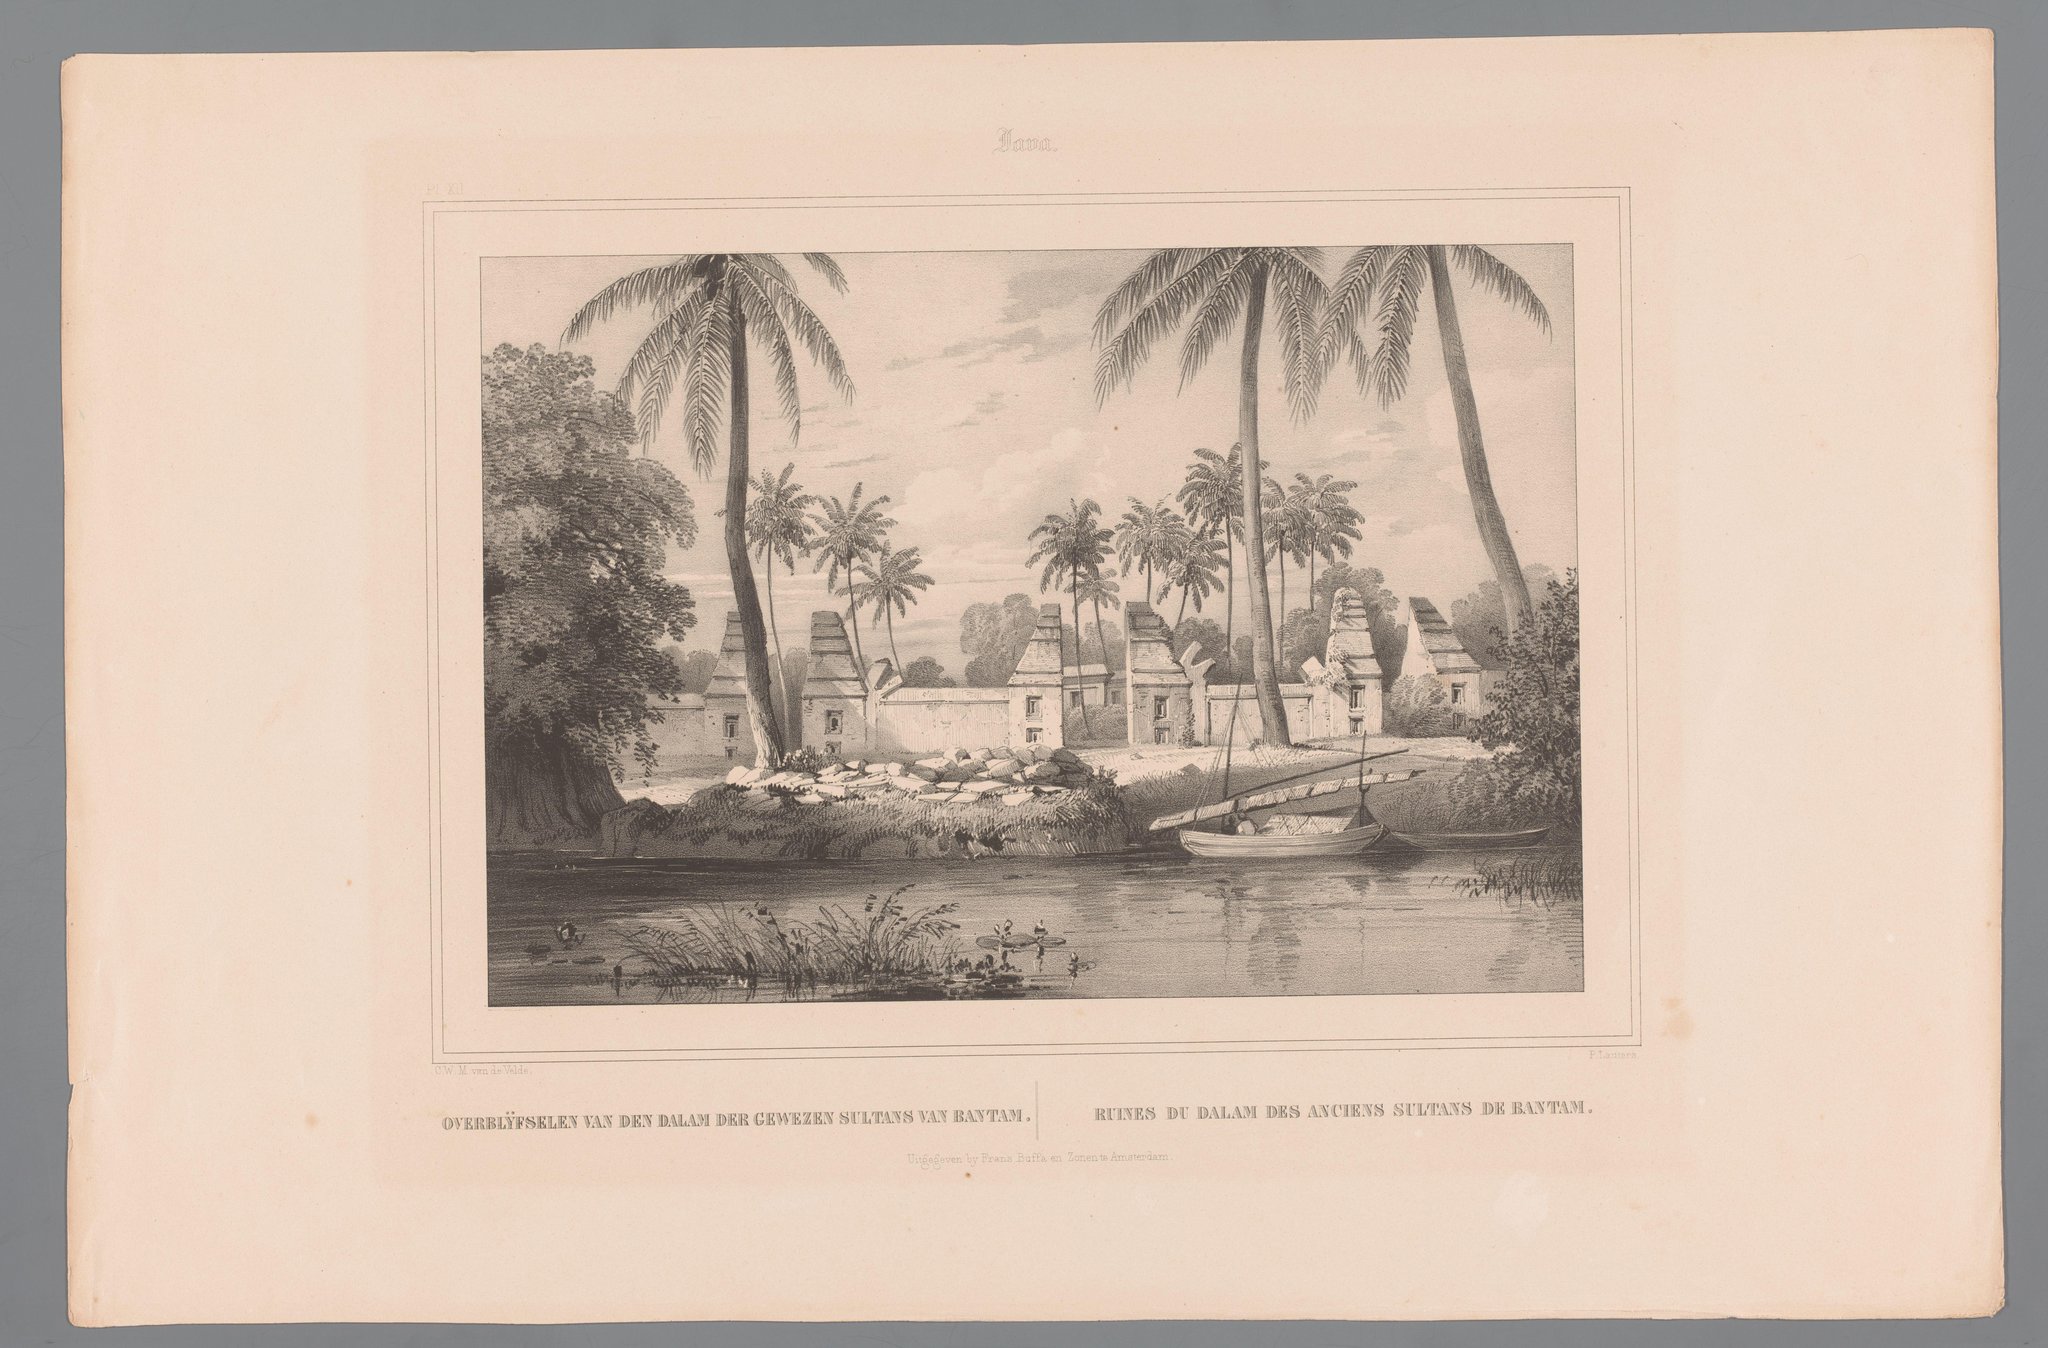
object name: print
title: Gezichten op Nederlands-Indië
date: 1847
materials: paper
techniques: lithograph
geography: amsterdam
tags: landscape with ruins, trees: palm-tree, traffic on the water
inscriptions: collector's mark: Lugt 2228